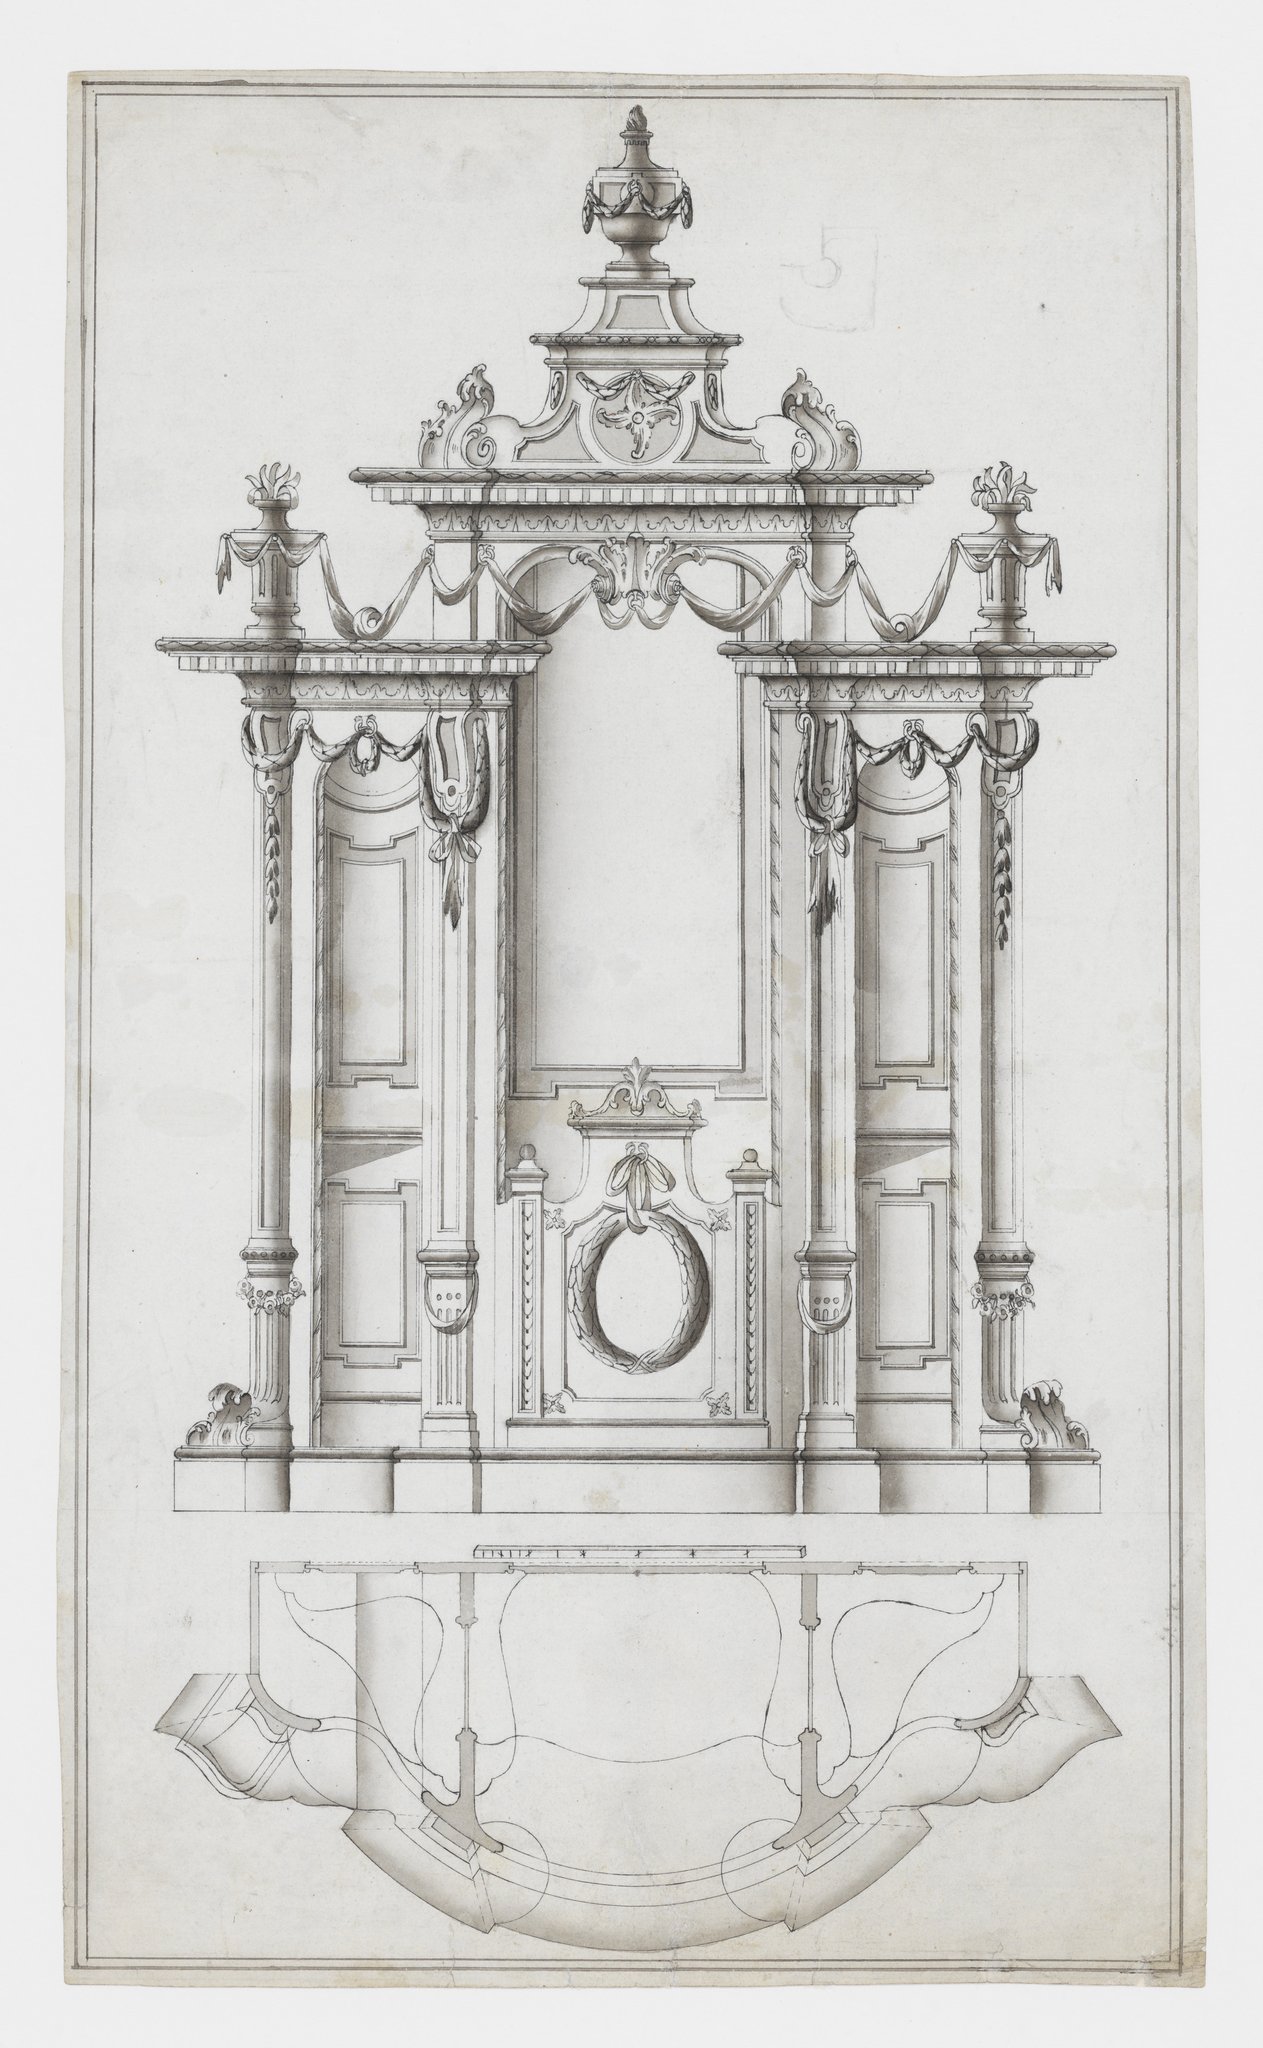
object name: ornament architecture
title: Elevation and Floorplan of a Neoclassical Confessional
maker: anonymous, central european, 18th century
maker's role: artist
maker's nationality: central european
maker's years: 1700-1800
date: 1760-1780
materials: ink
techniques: brush, pen, wash